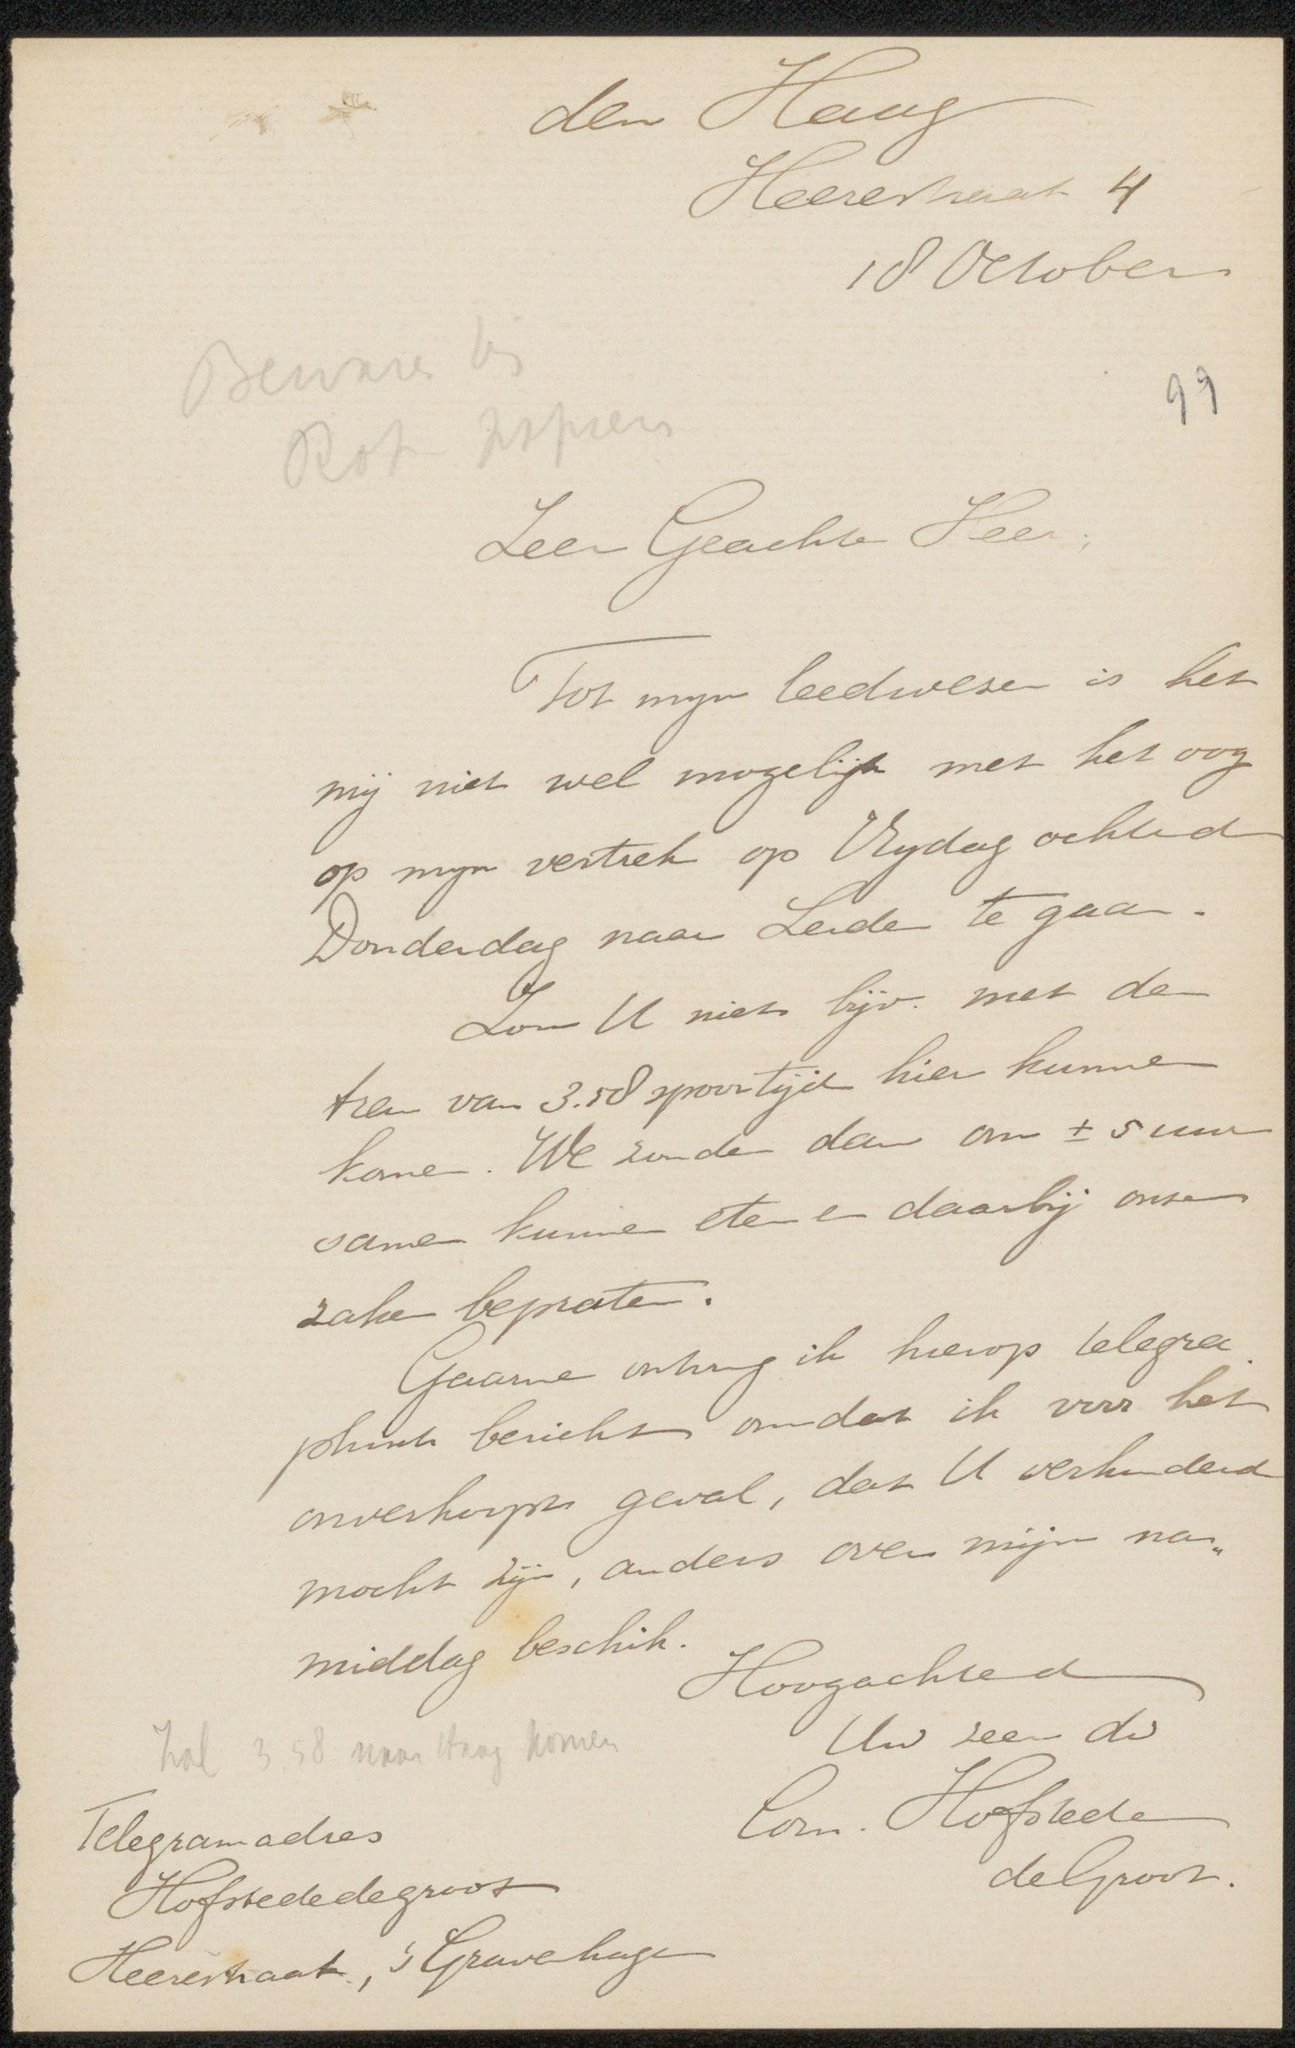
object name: letter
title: Brief aan Jan Veth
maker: cornelis hofstede de groot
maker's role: kunsthistoricus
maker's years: 1863-1940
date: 1874-1925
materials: ink, paper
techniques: pen, writing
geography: the hague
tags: dordrecht, amsterdam, painter, draughtsman, designer, jan veth, leiden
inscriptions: collector's mark: ‘RPK’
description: Brief gedateerd 18 October door schrijver, met toevoeging 99 in latere hand.